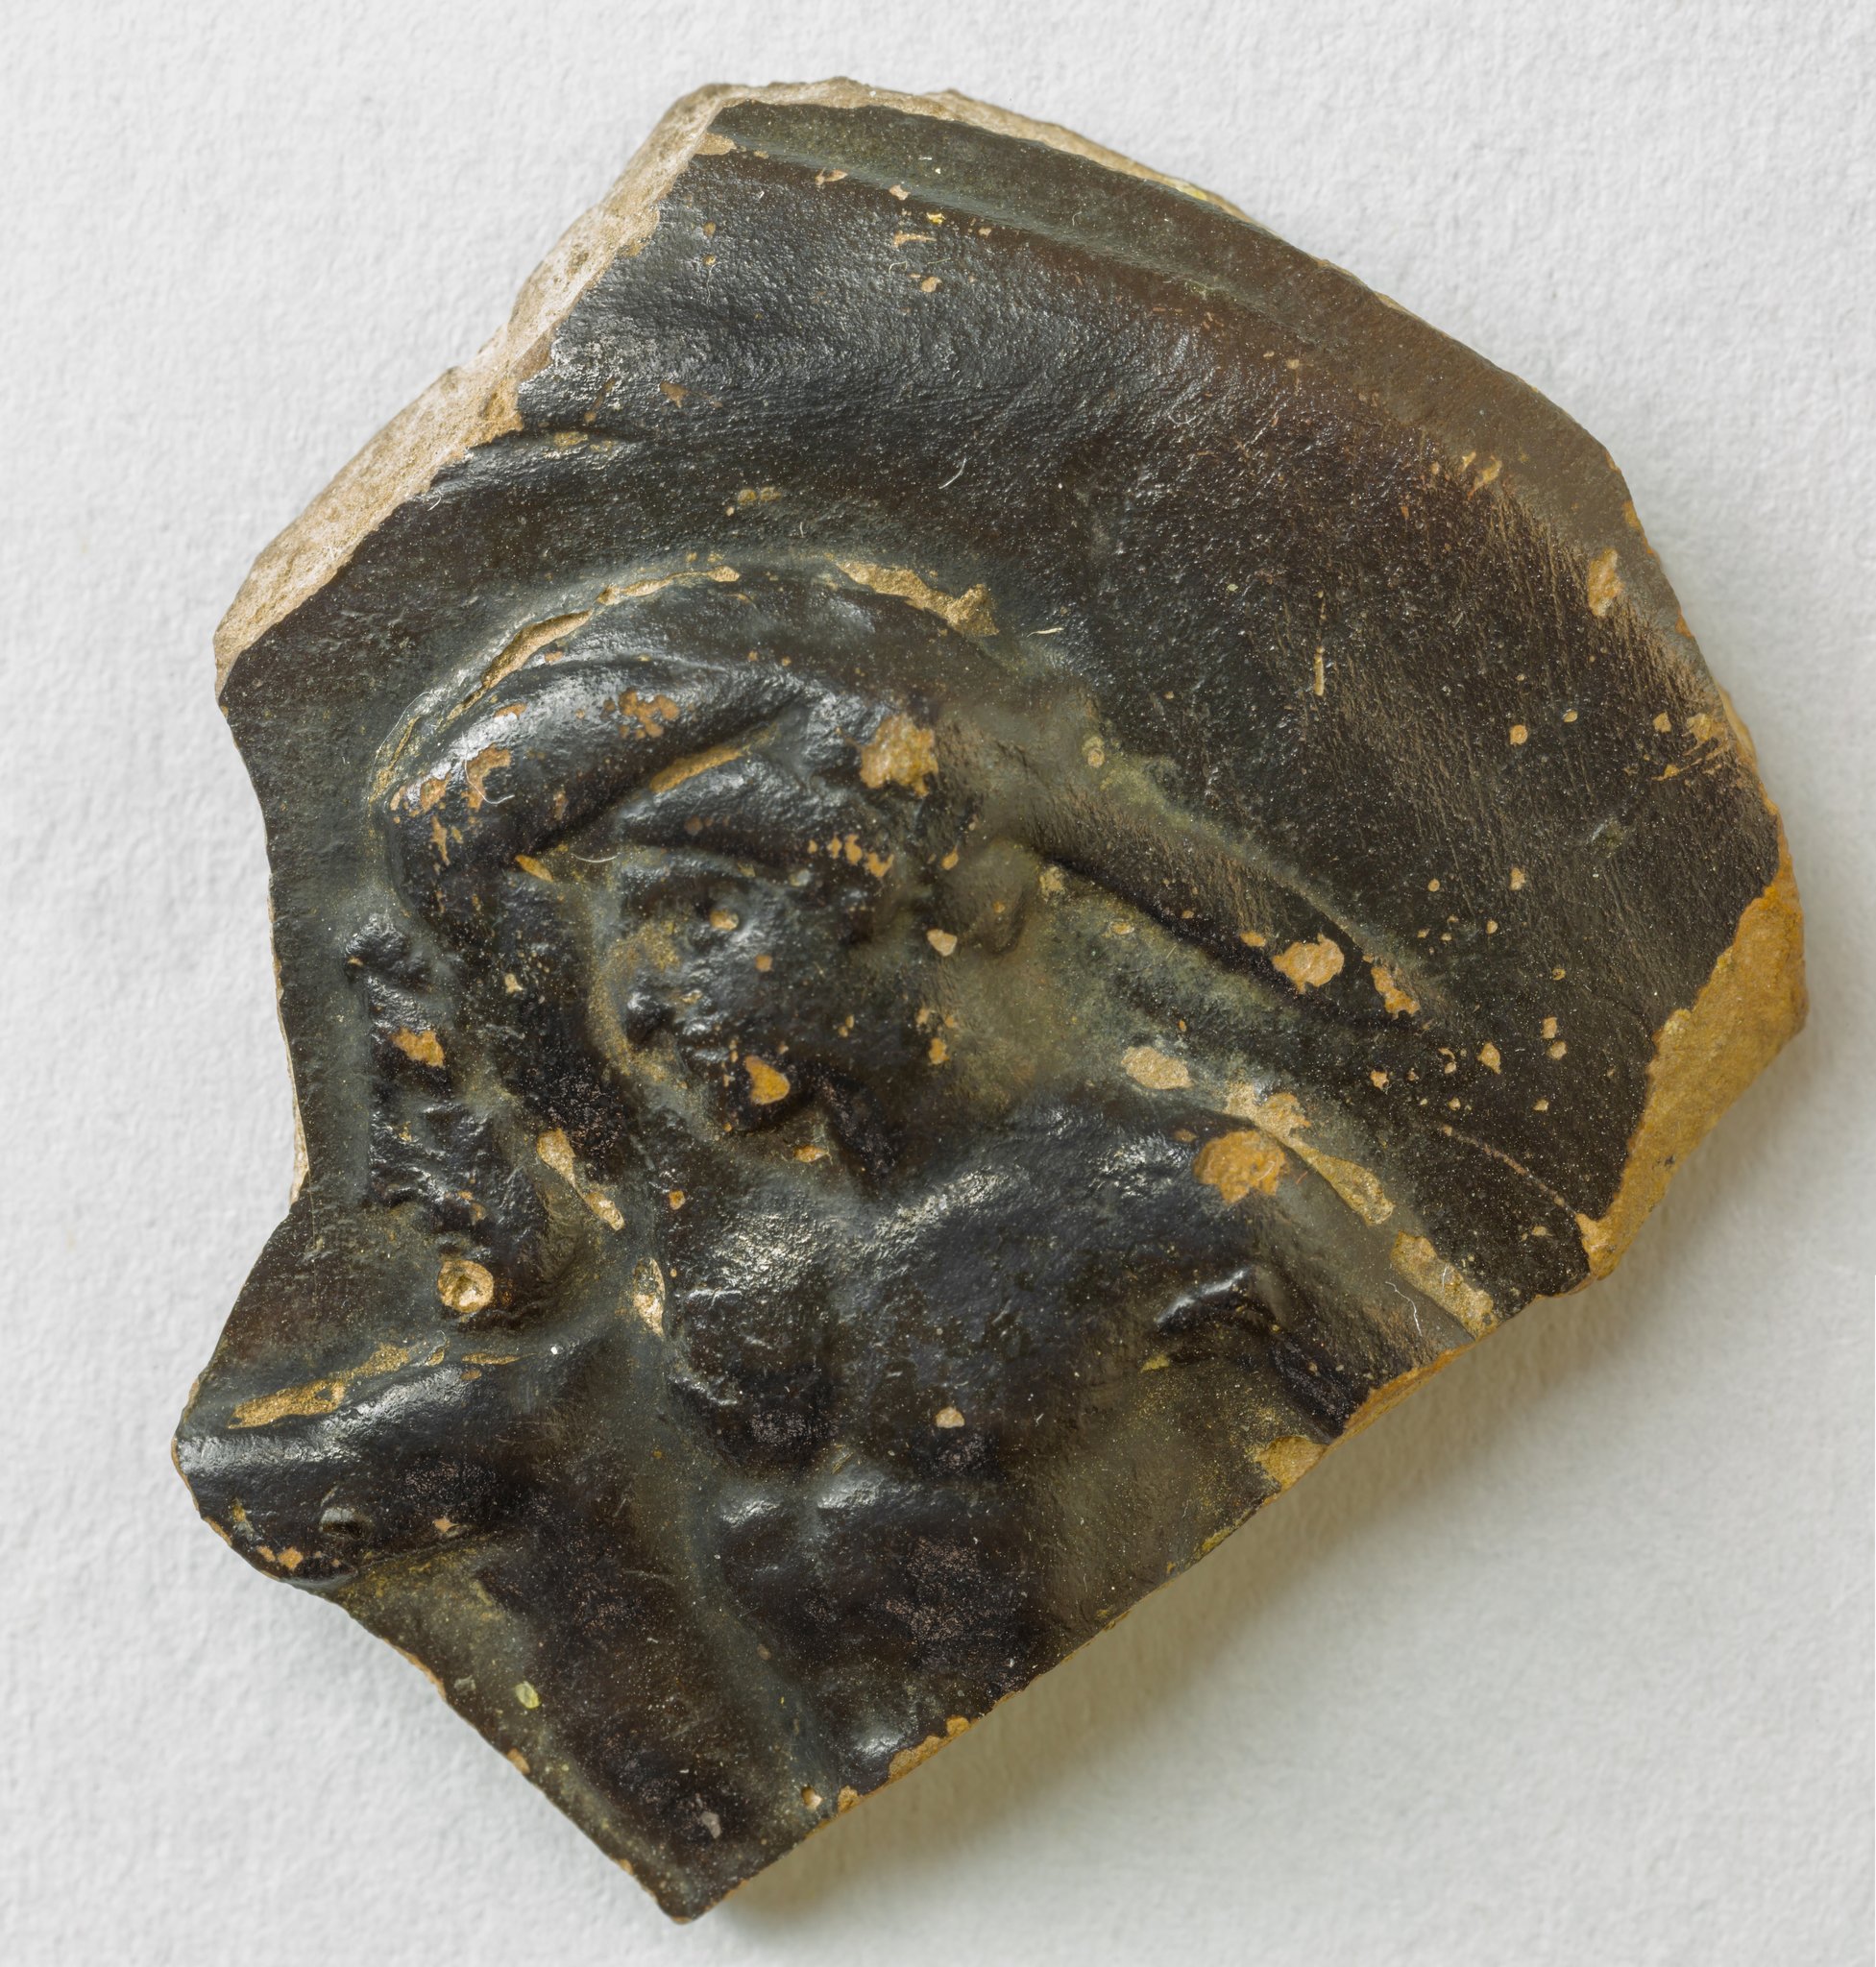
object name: guttus fragment with harmodios and aristogeiton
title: Fragment of a terracotta guttus (oil flask)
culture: greek or south italian or campanian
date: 300-201 BCE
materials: terracotta